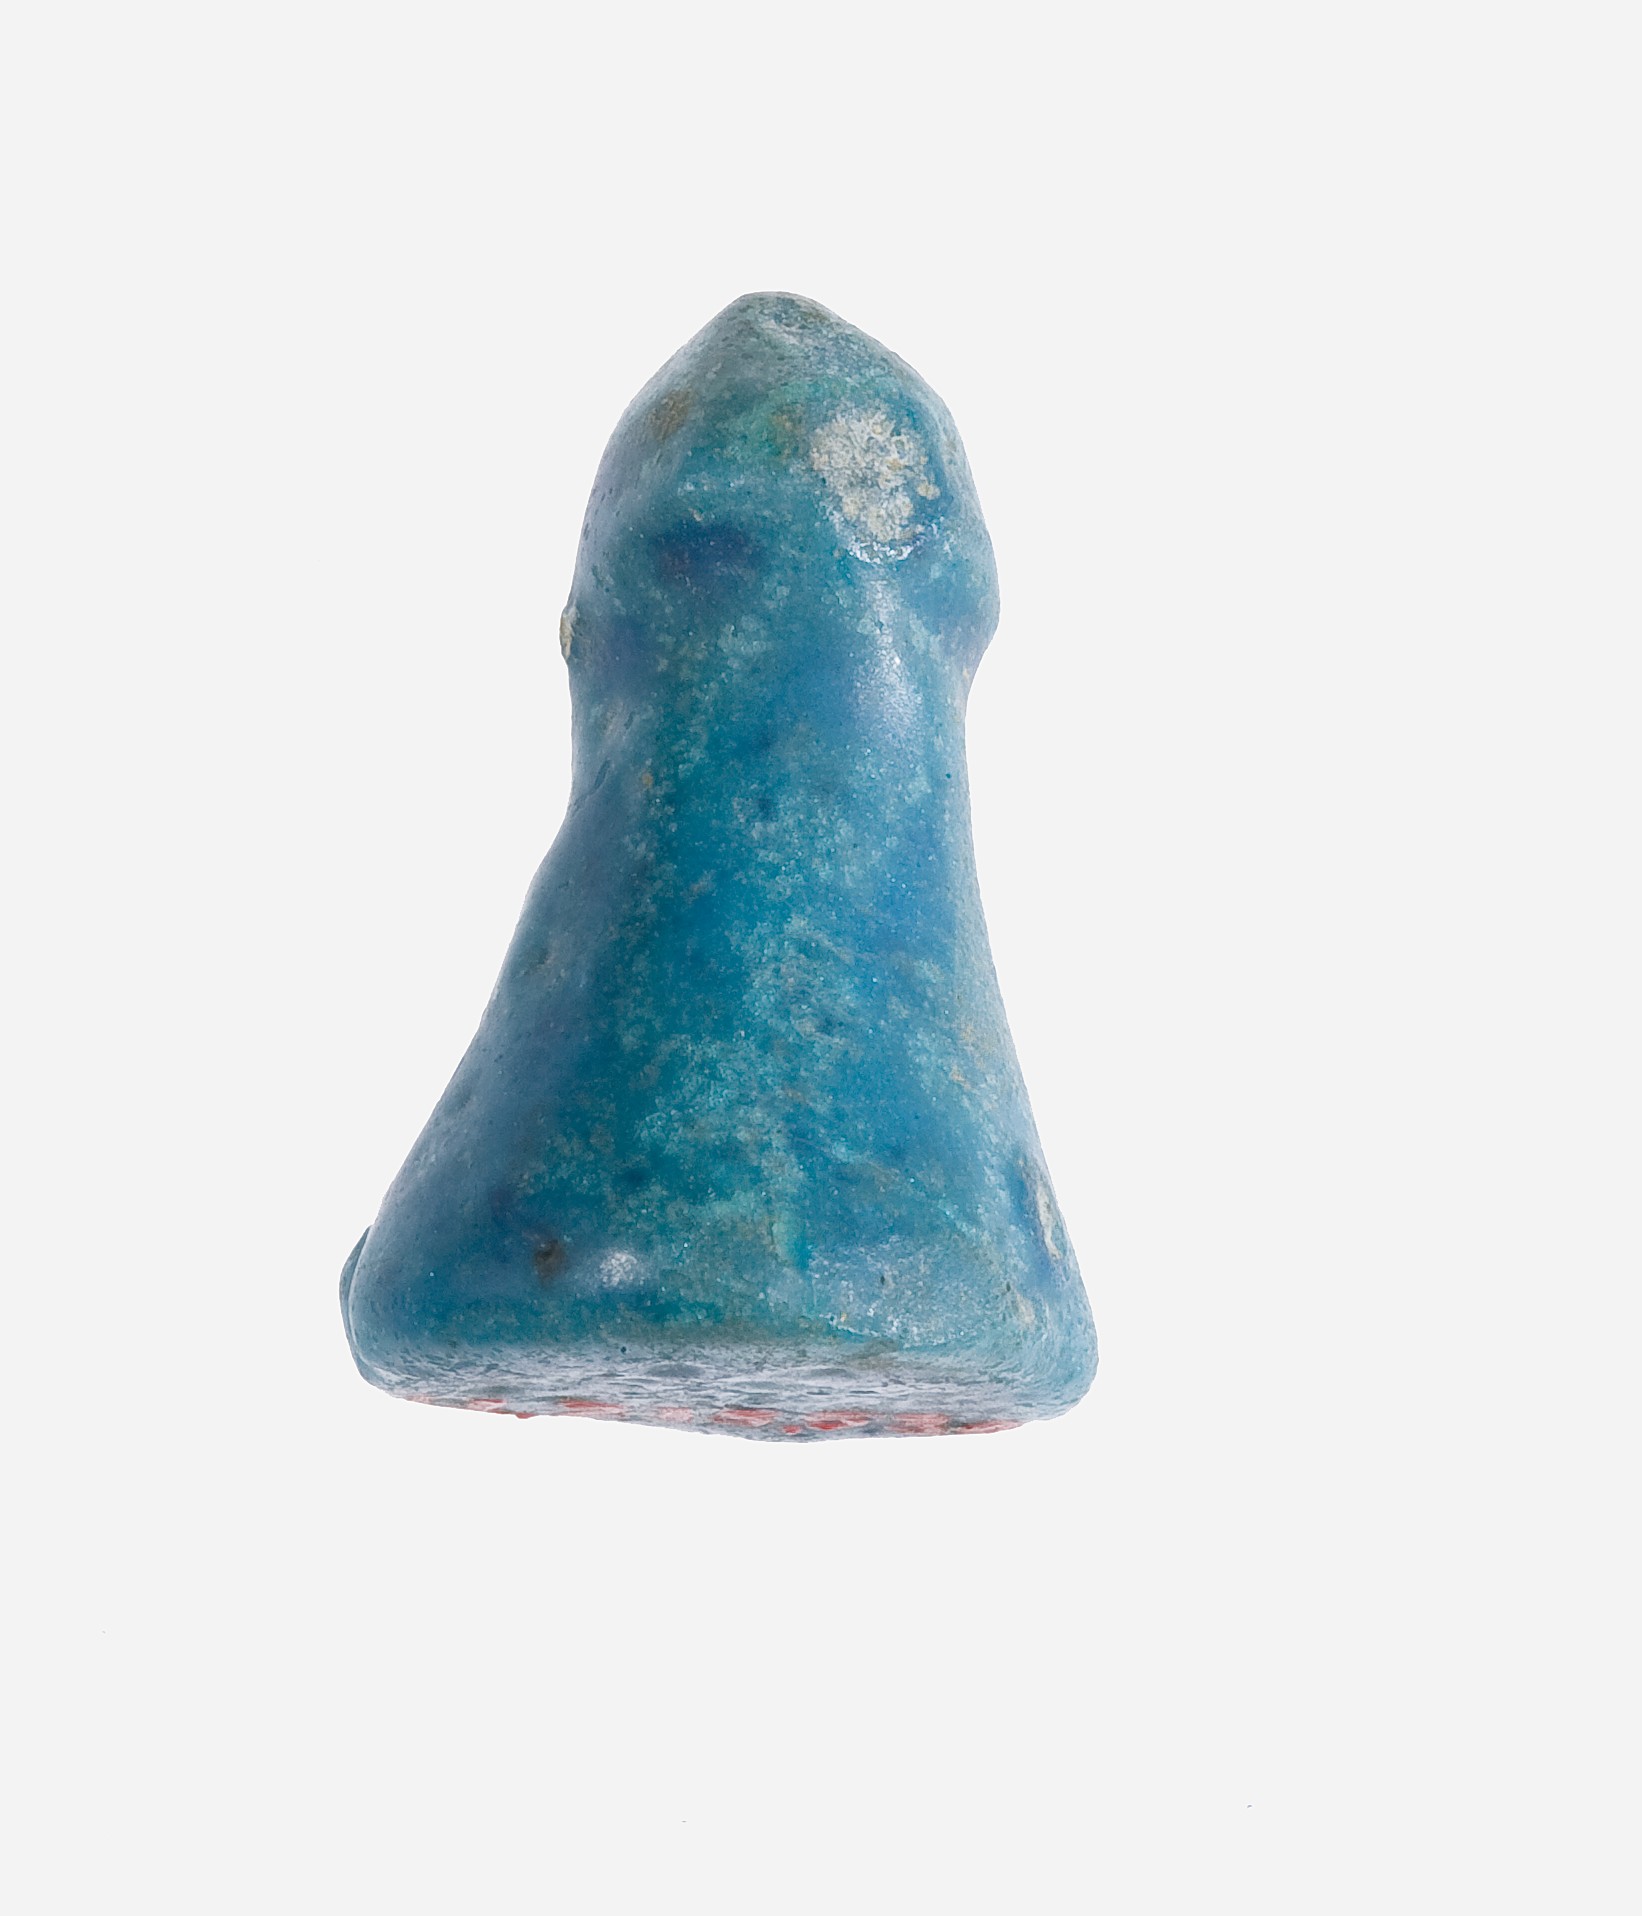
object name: game piece, conical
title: Conical Game Piece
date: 1390-1352 BCE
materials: faience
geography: egypt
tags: games